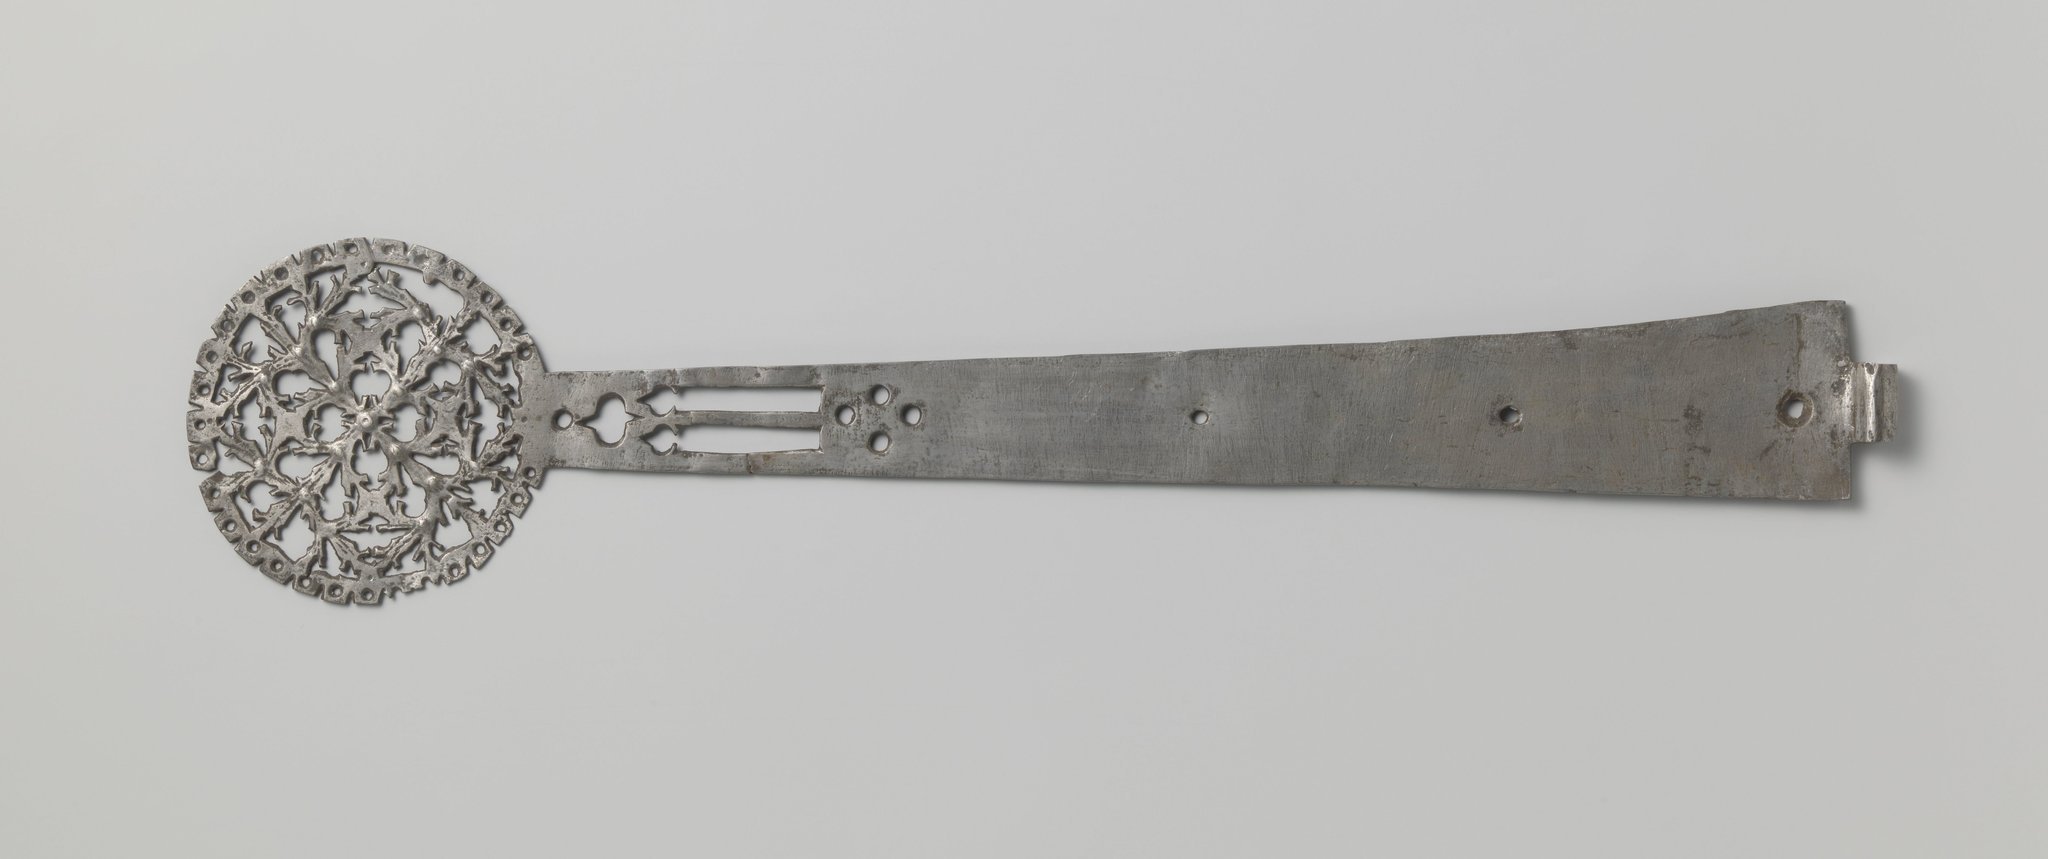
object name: hengsel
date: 1400-1950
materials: iron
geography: italy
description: Hengsel met cirkelvormig ornament. Afkomstig van een Noord Italiaanse of Zuid Duitse kist.